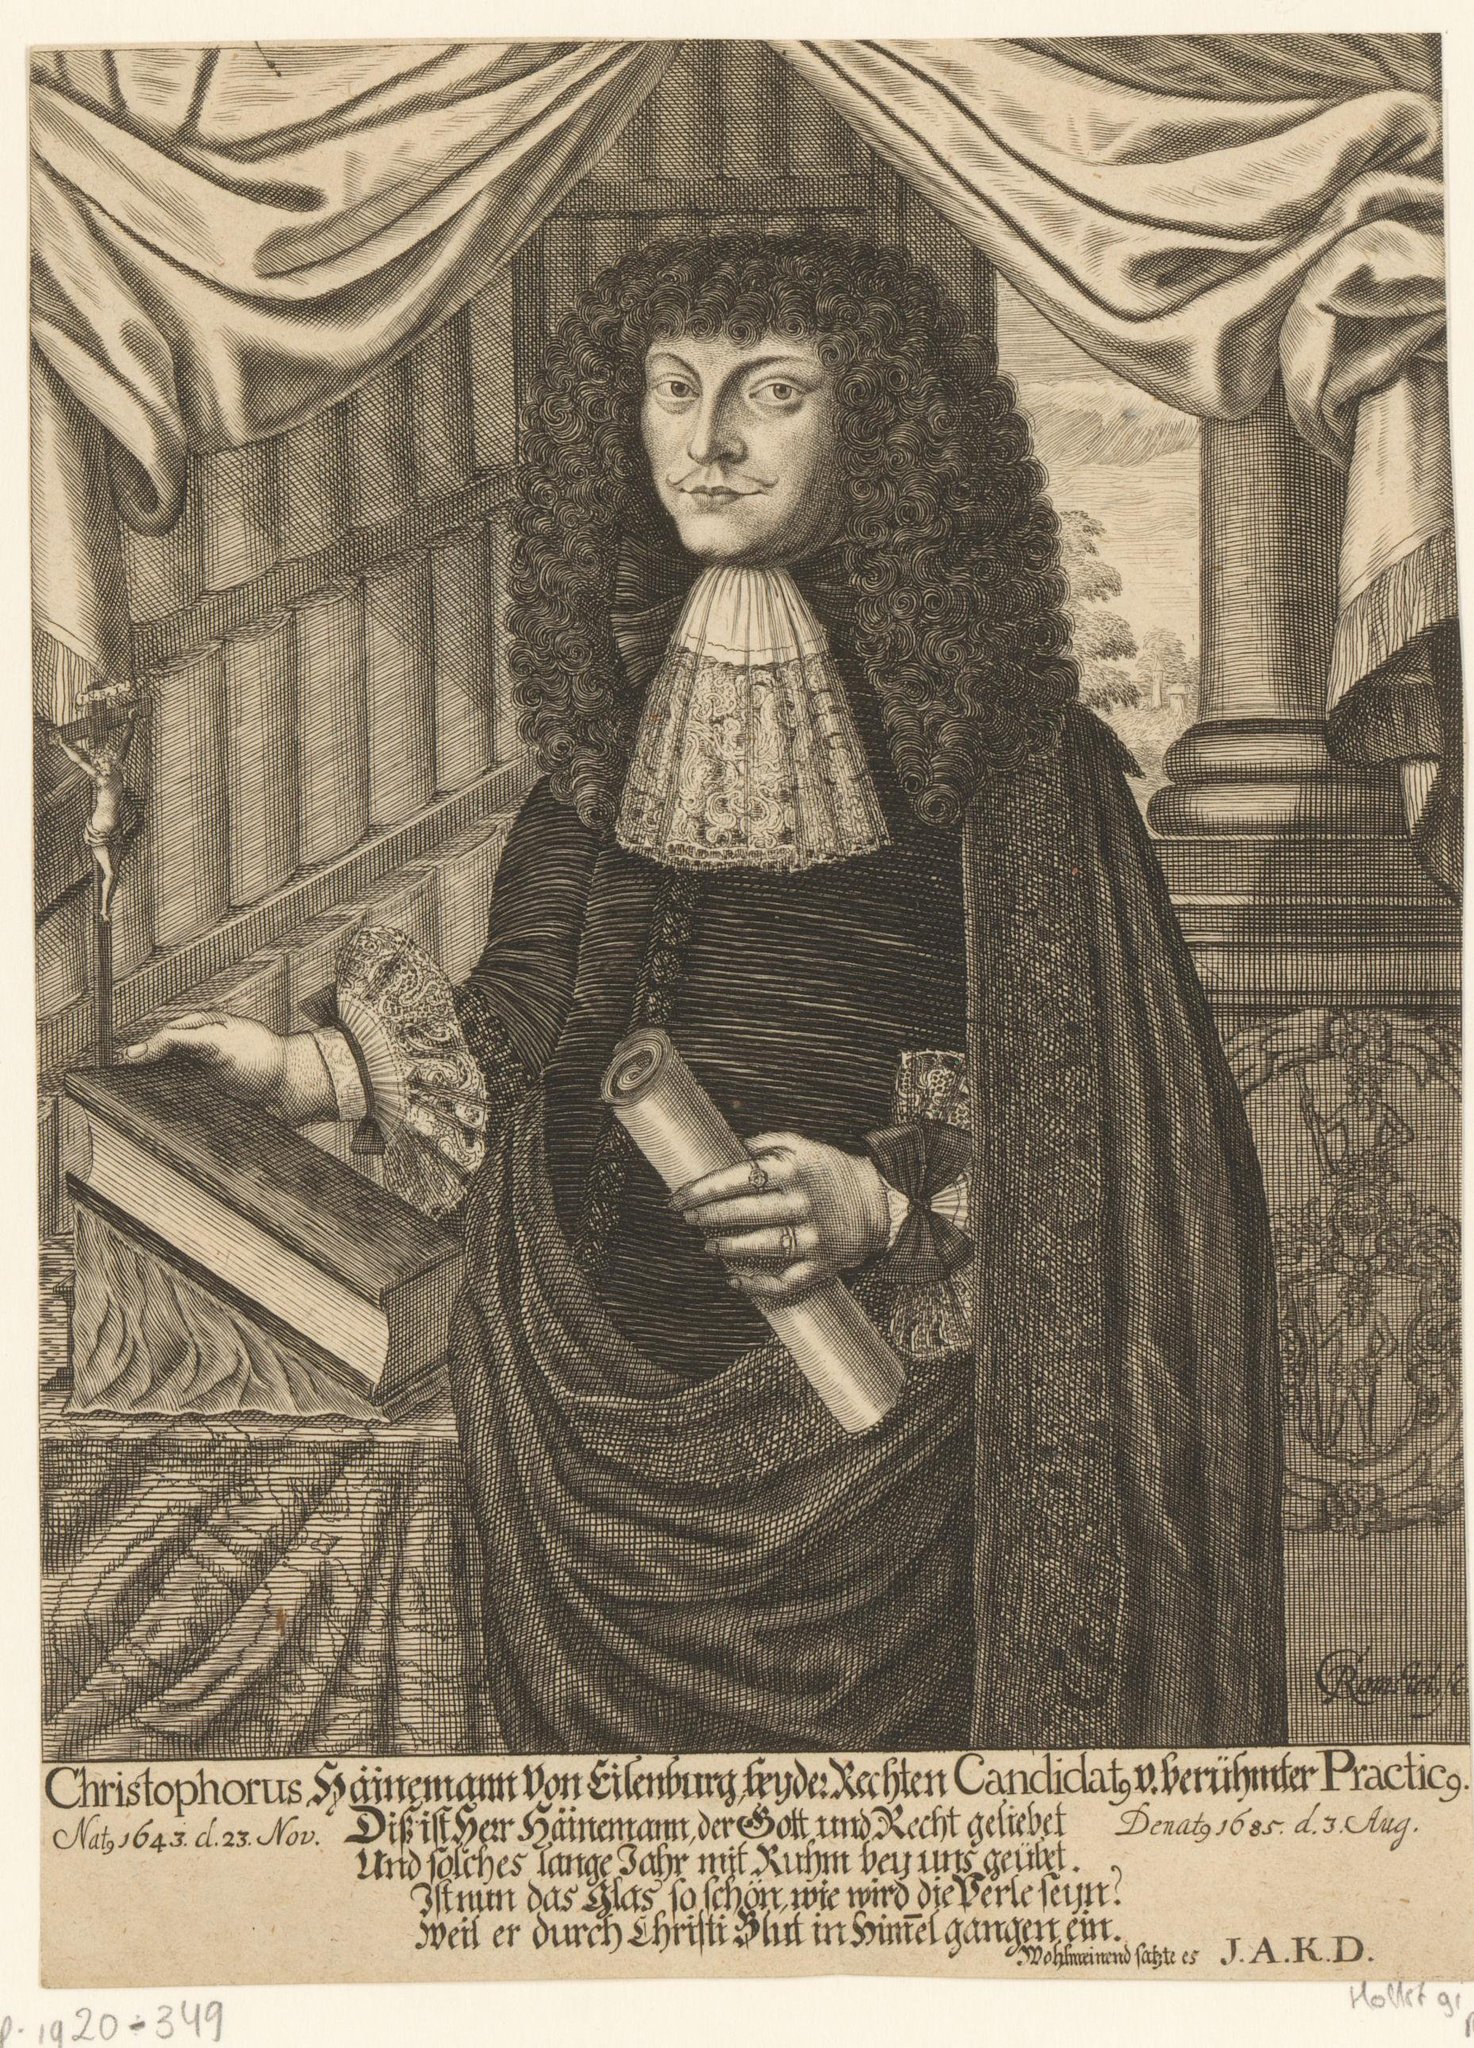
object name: print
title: Portret van Christoph Hainemann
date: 1685-1721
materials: paper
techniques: engraving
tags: bookshelves, historical persons, book, crucifix ~ personal devotion, scroll, armorial bearing, heraldry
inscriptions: collector's mark: Lugt 2228